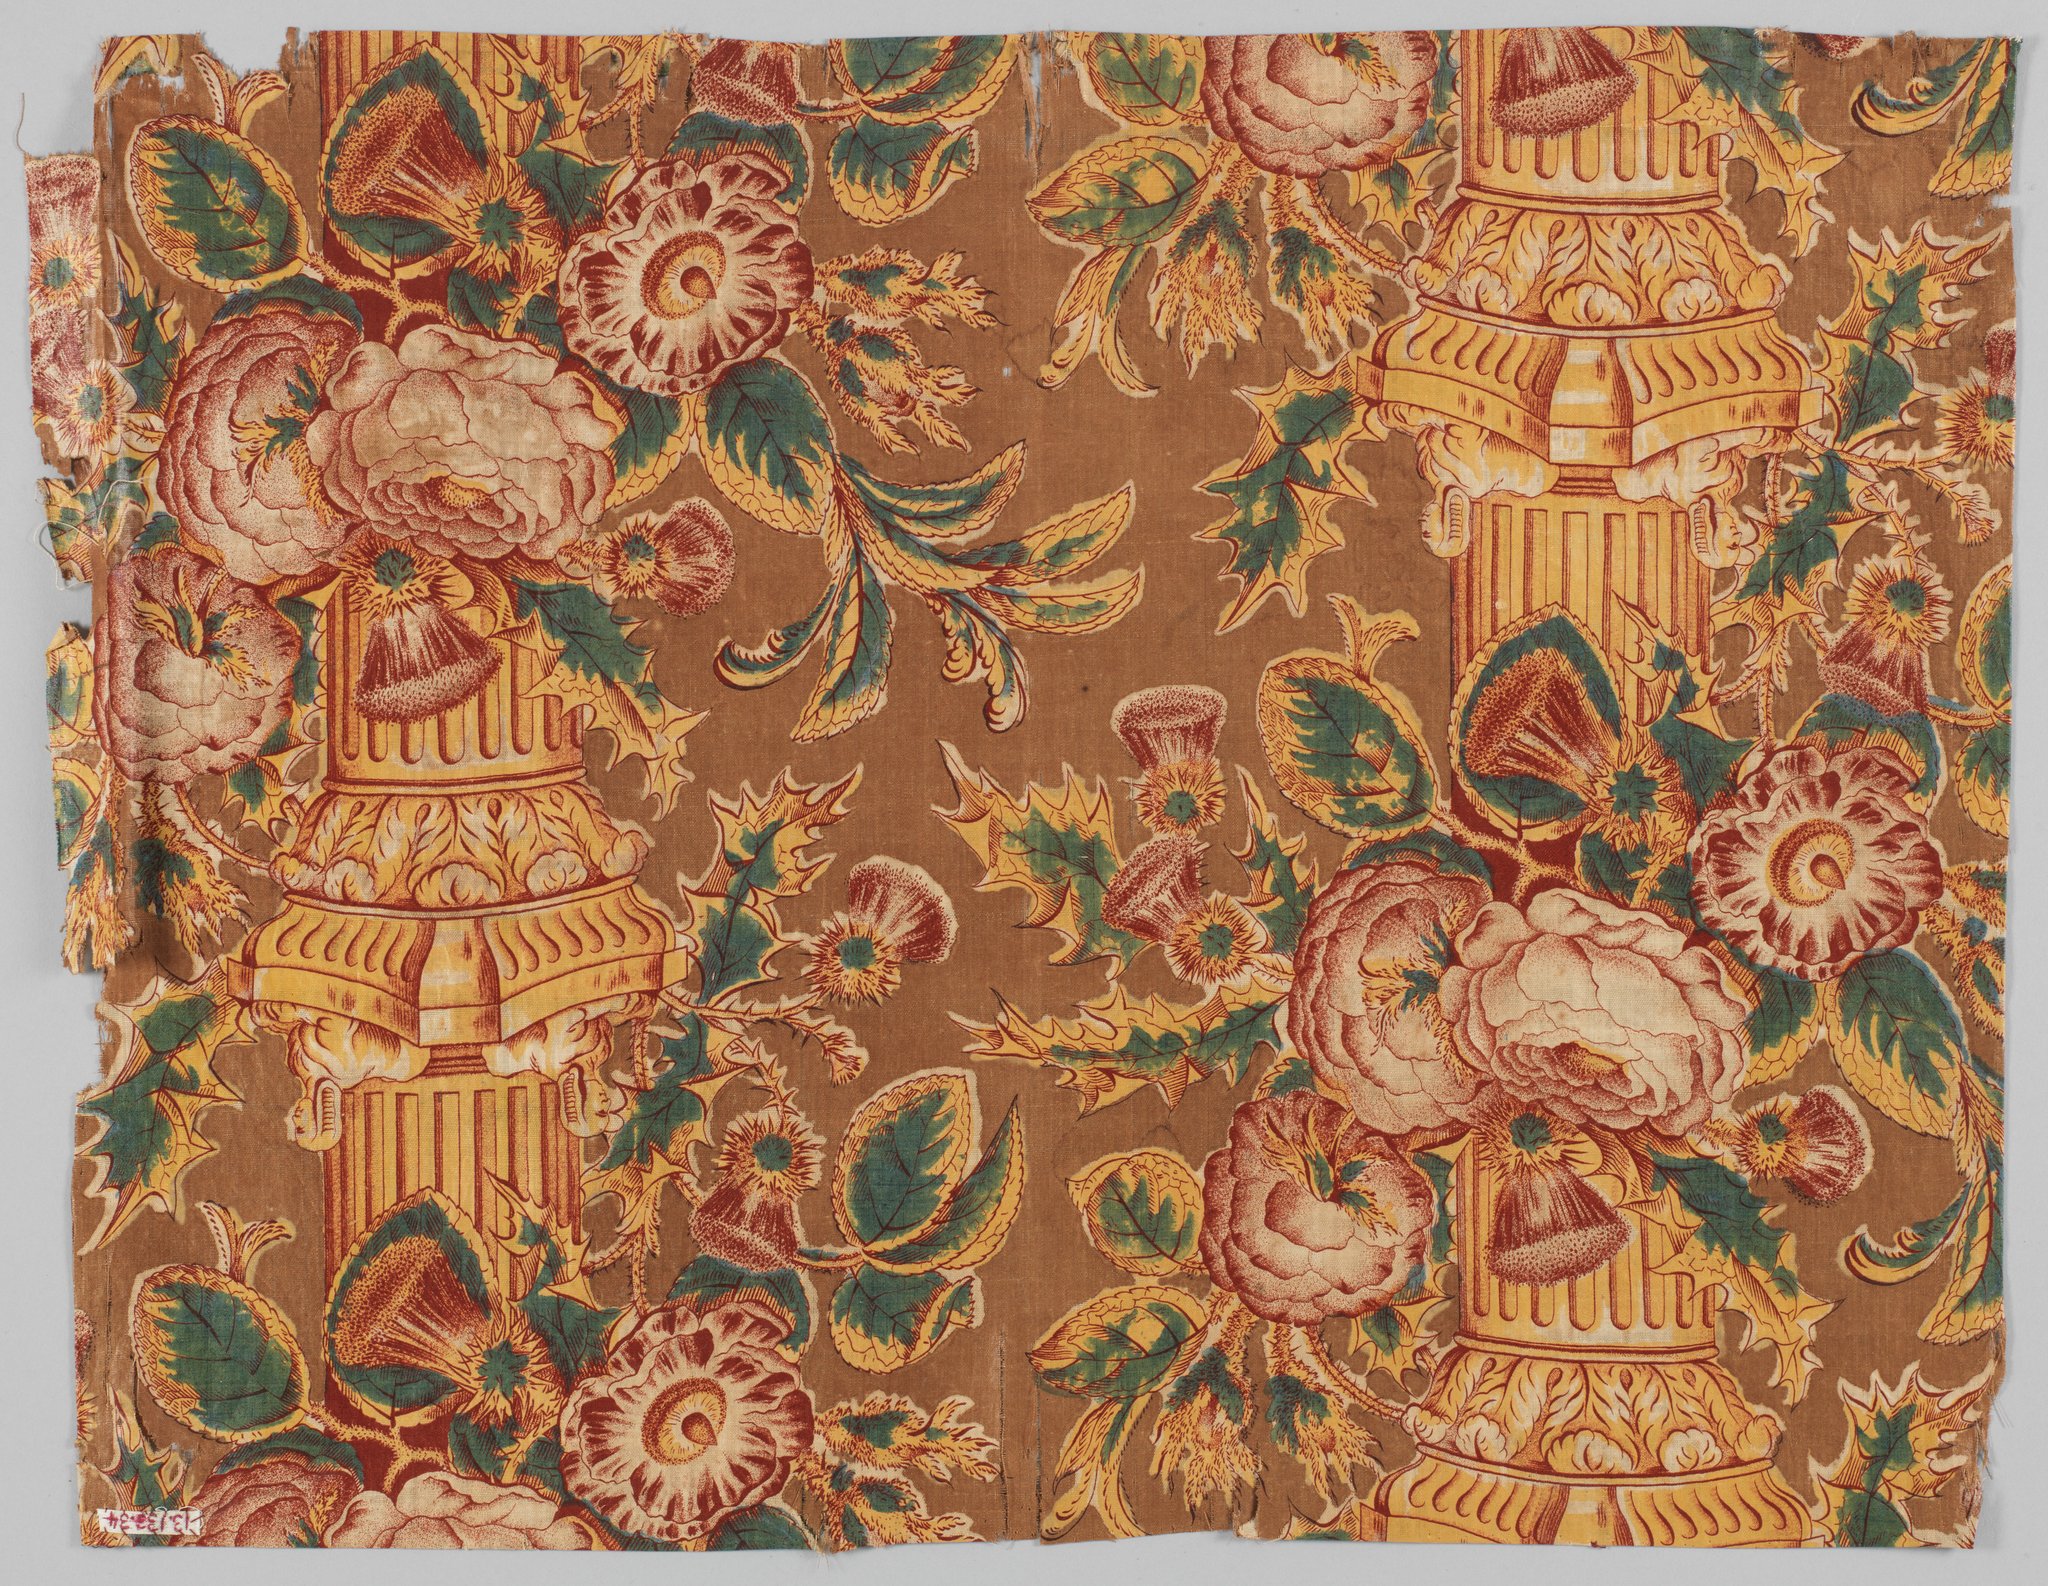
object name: piece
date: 1825-1830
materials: cotton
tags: columns,flowers